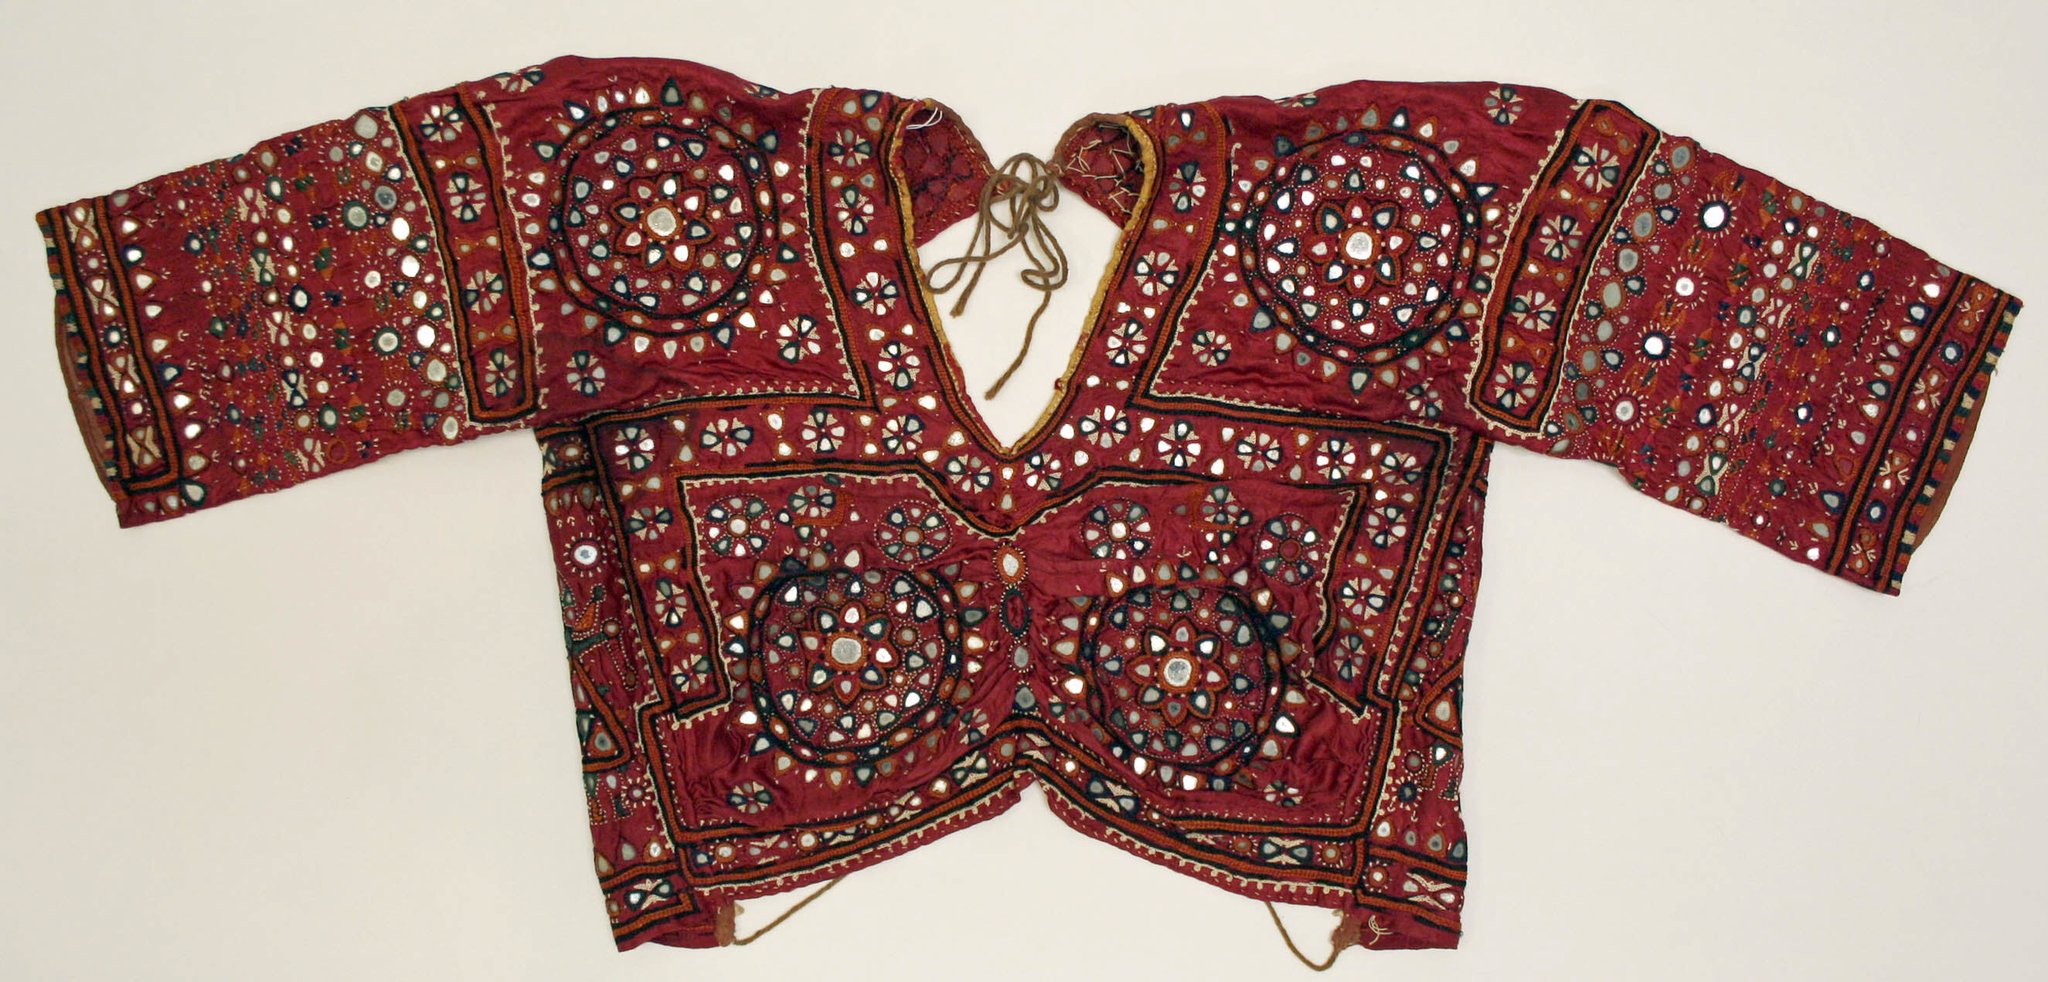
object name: choli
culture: indian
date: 1801-1900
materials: silk